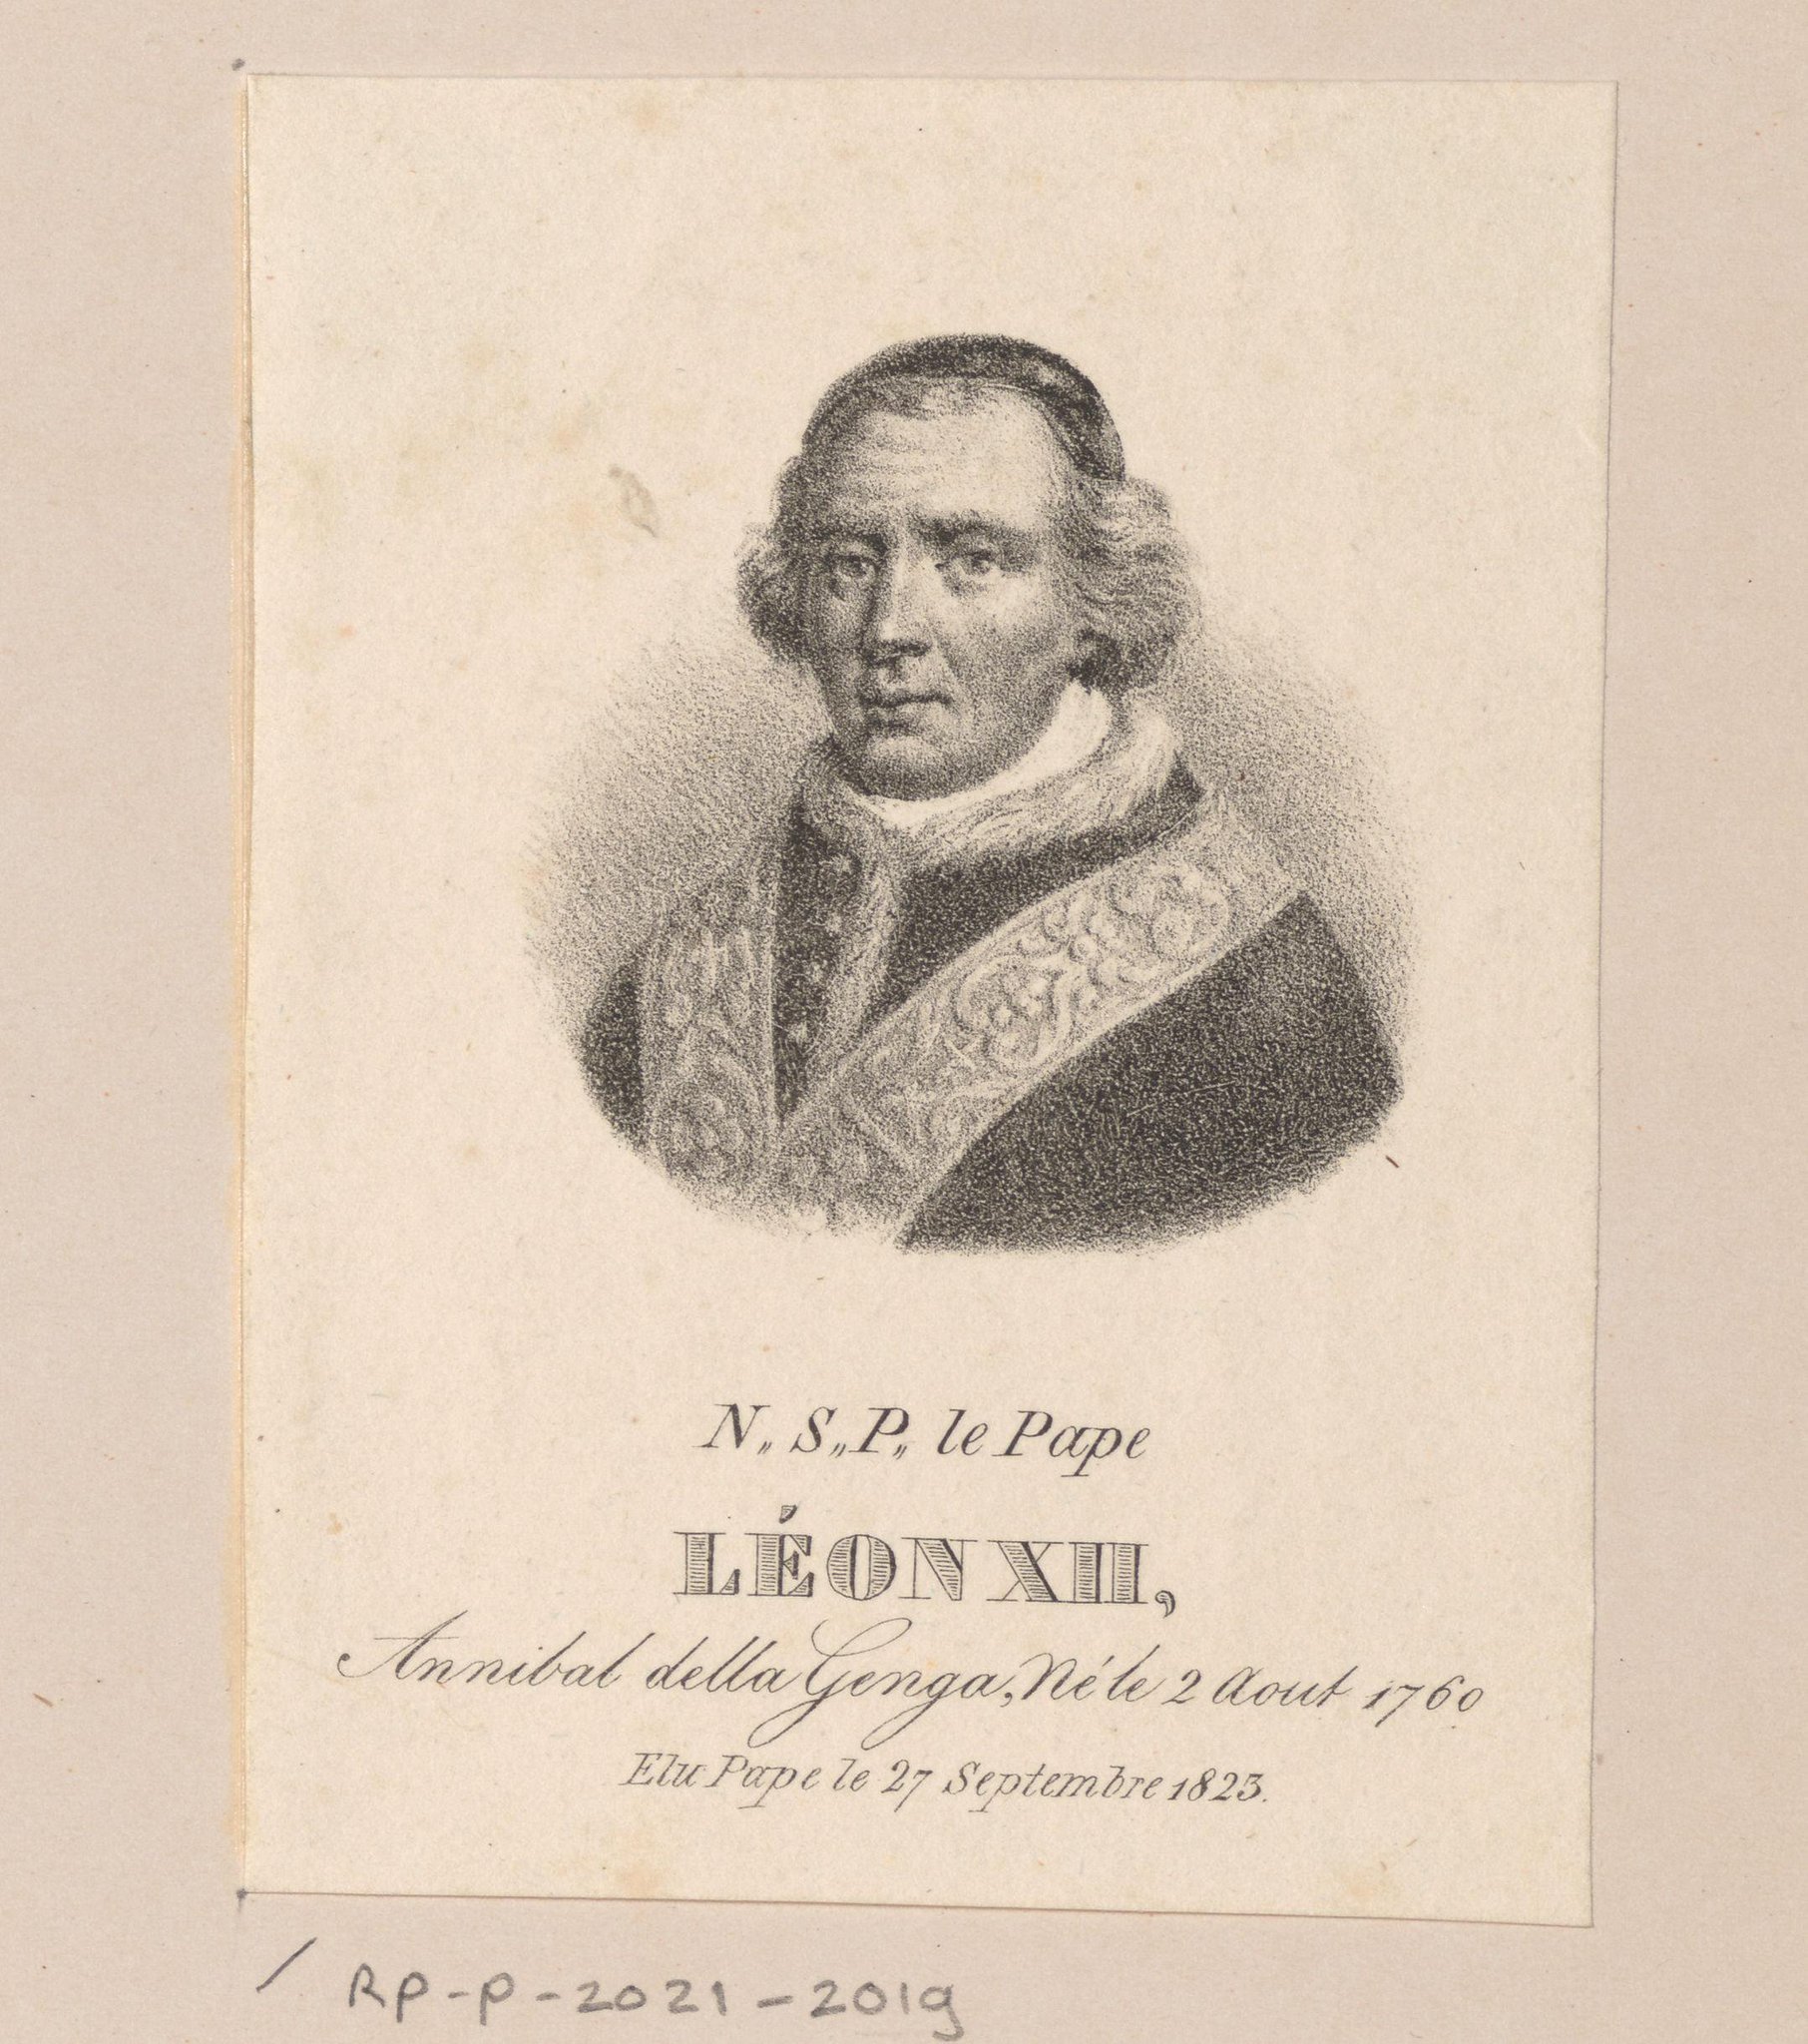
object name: print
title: Portret van paus Leo XII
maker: Anonymous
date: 1823-1899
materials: paper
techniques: lithograph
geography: france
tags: rome, historical persons, pope